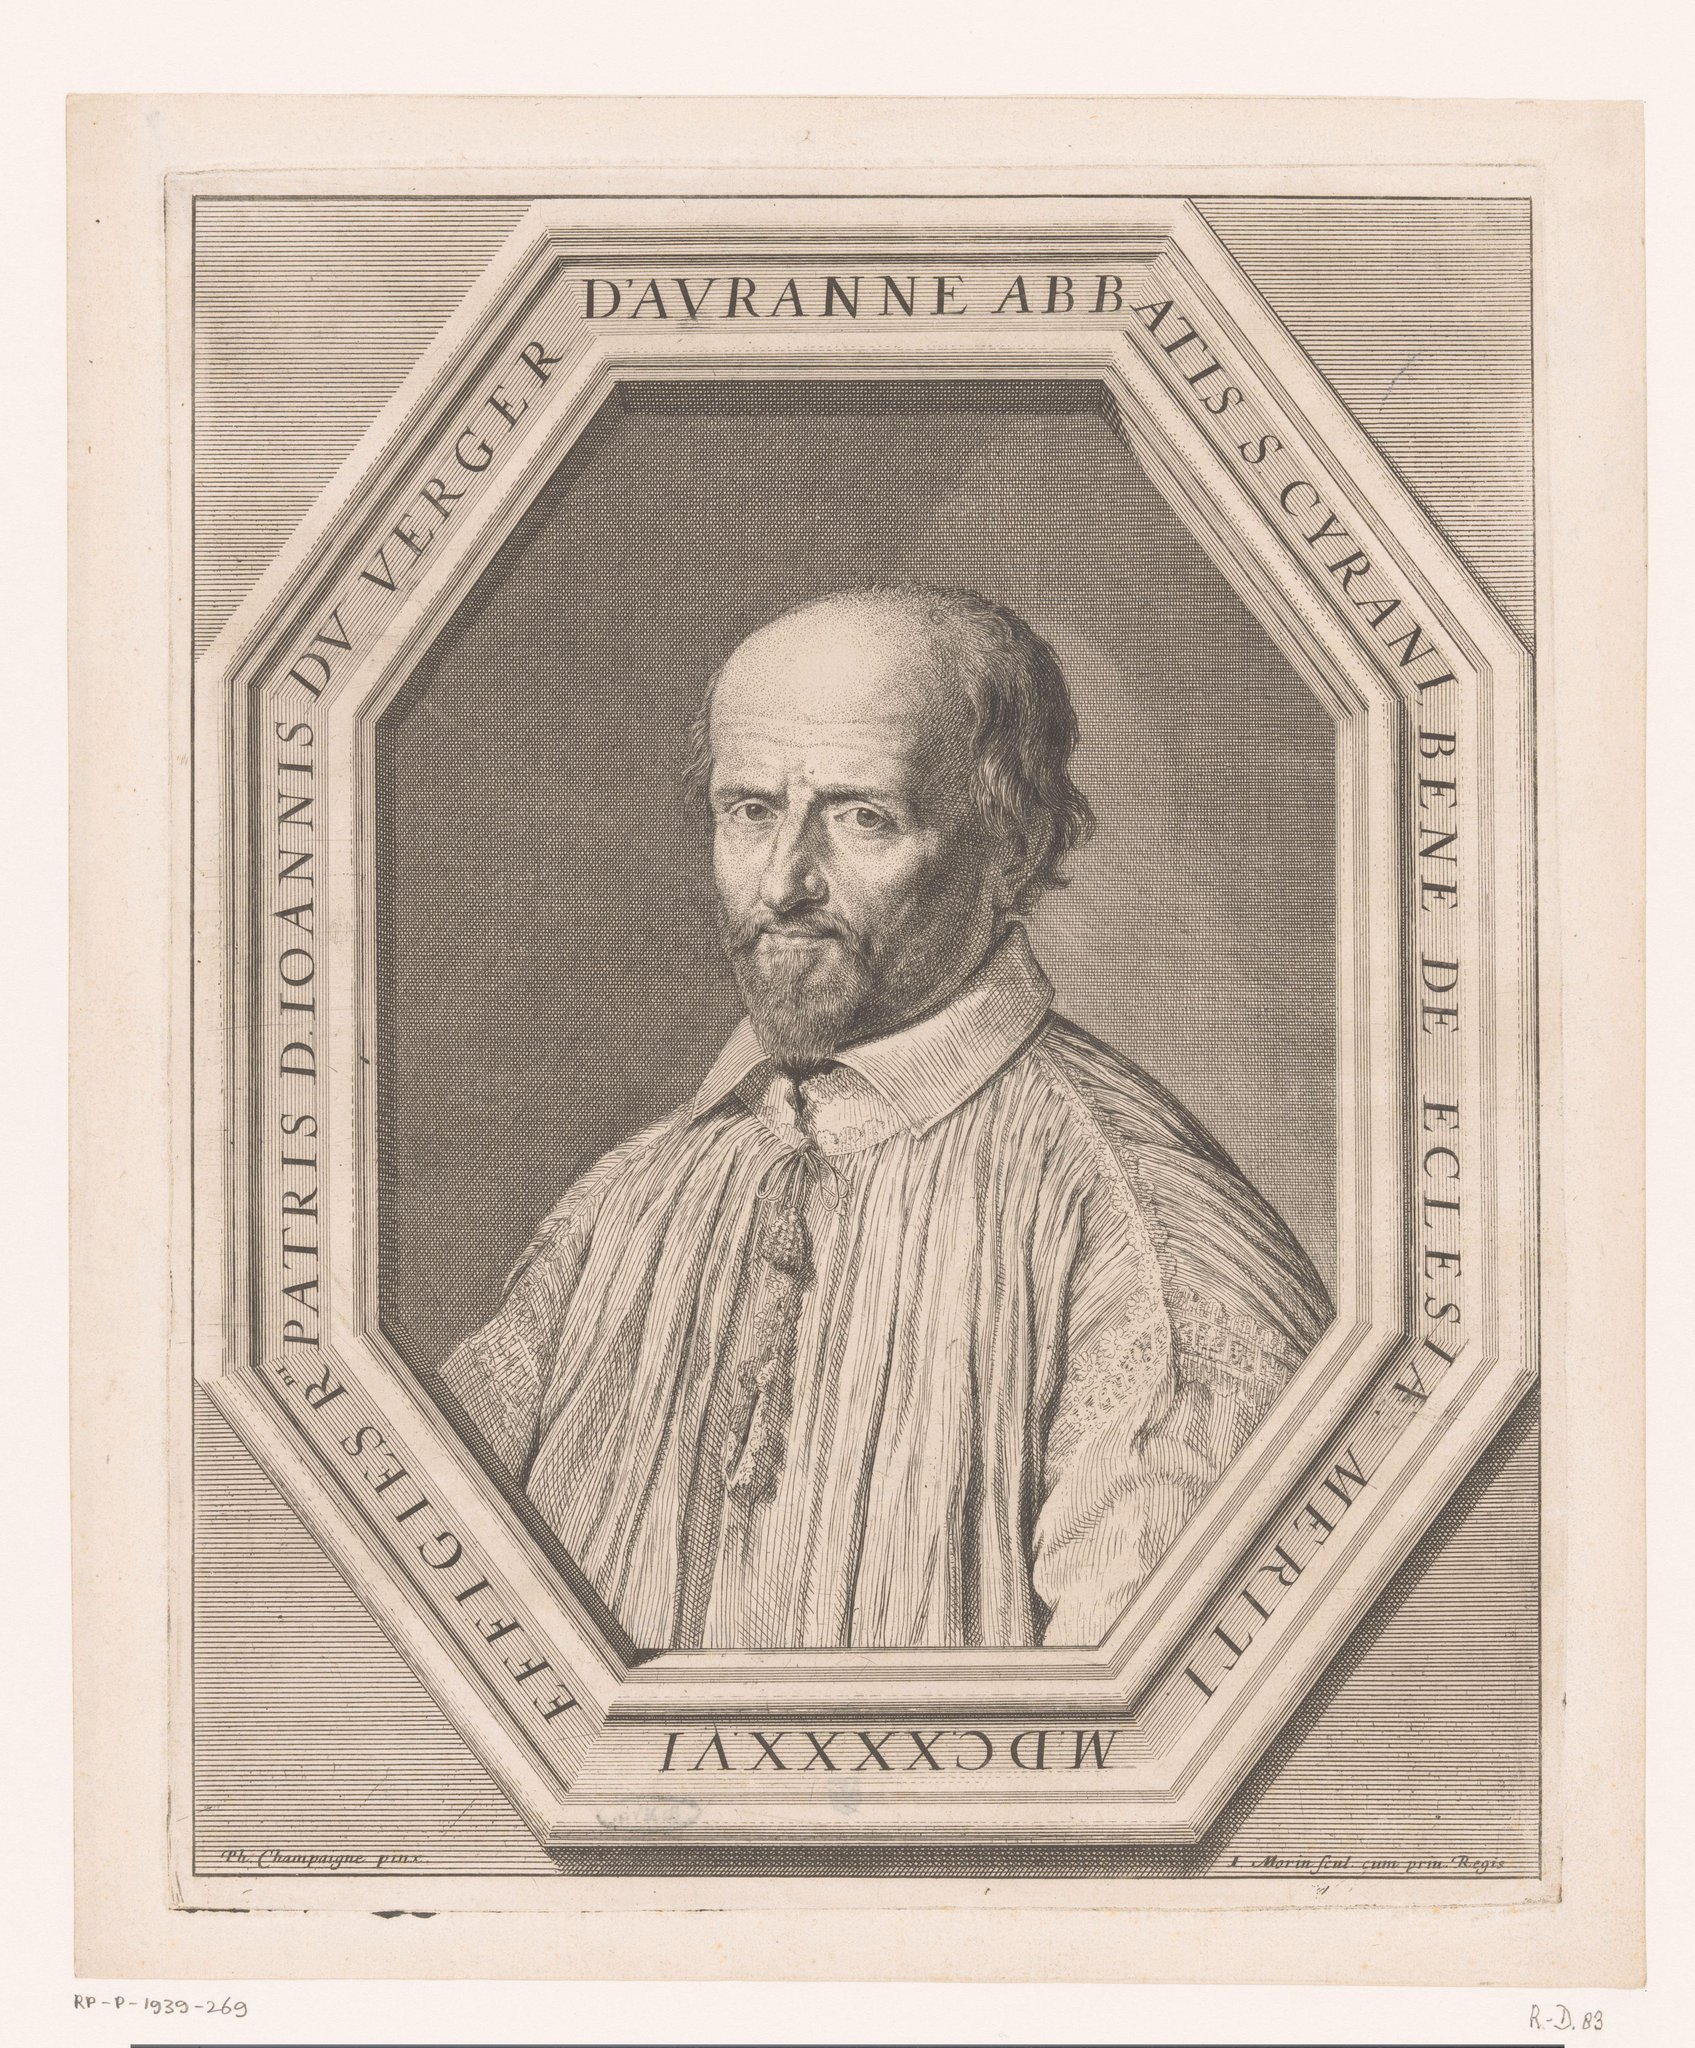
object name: print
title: Portret van Jean Duvergier de Hauranne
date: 1610-1650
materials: paper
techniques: etching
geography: france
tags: paris, priest, historical persons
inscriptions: collector's mark: Lugt 2228